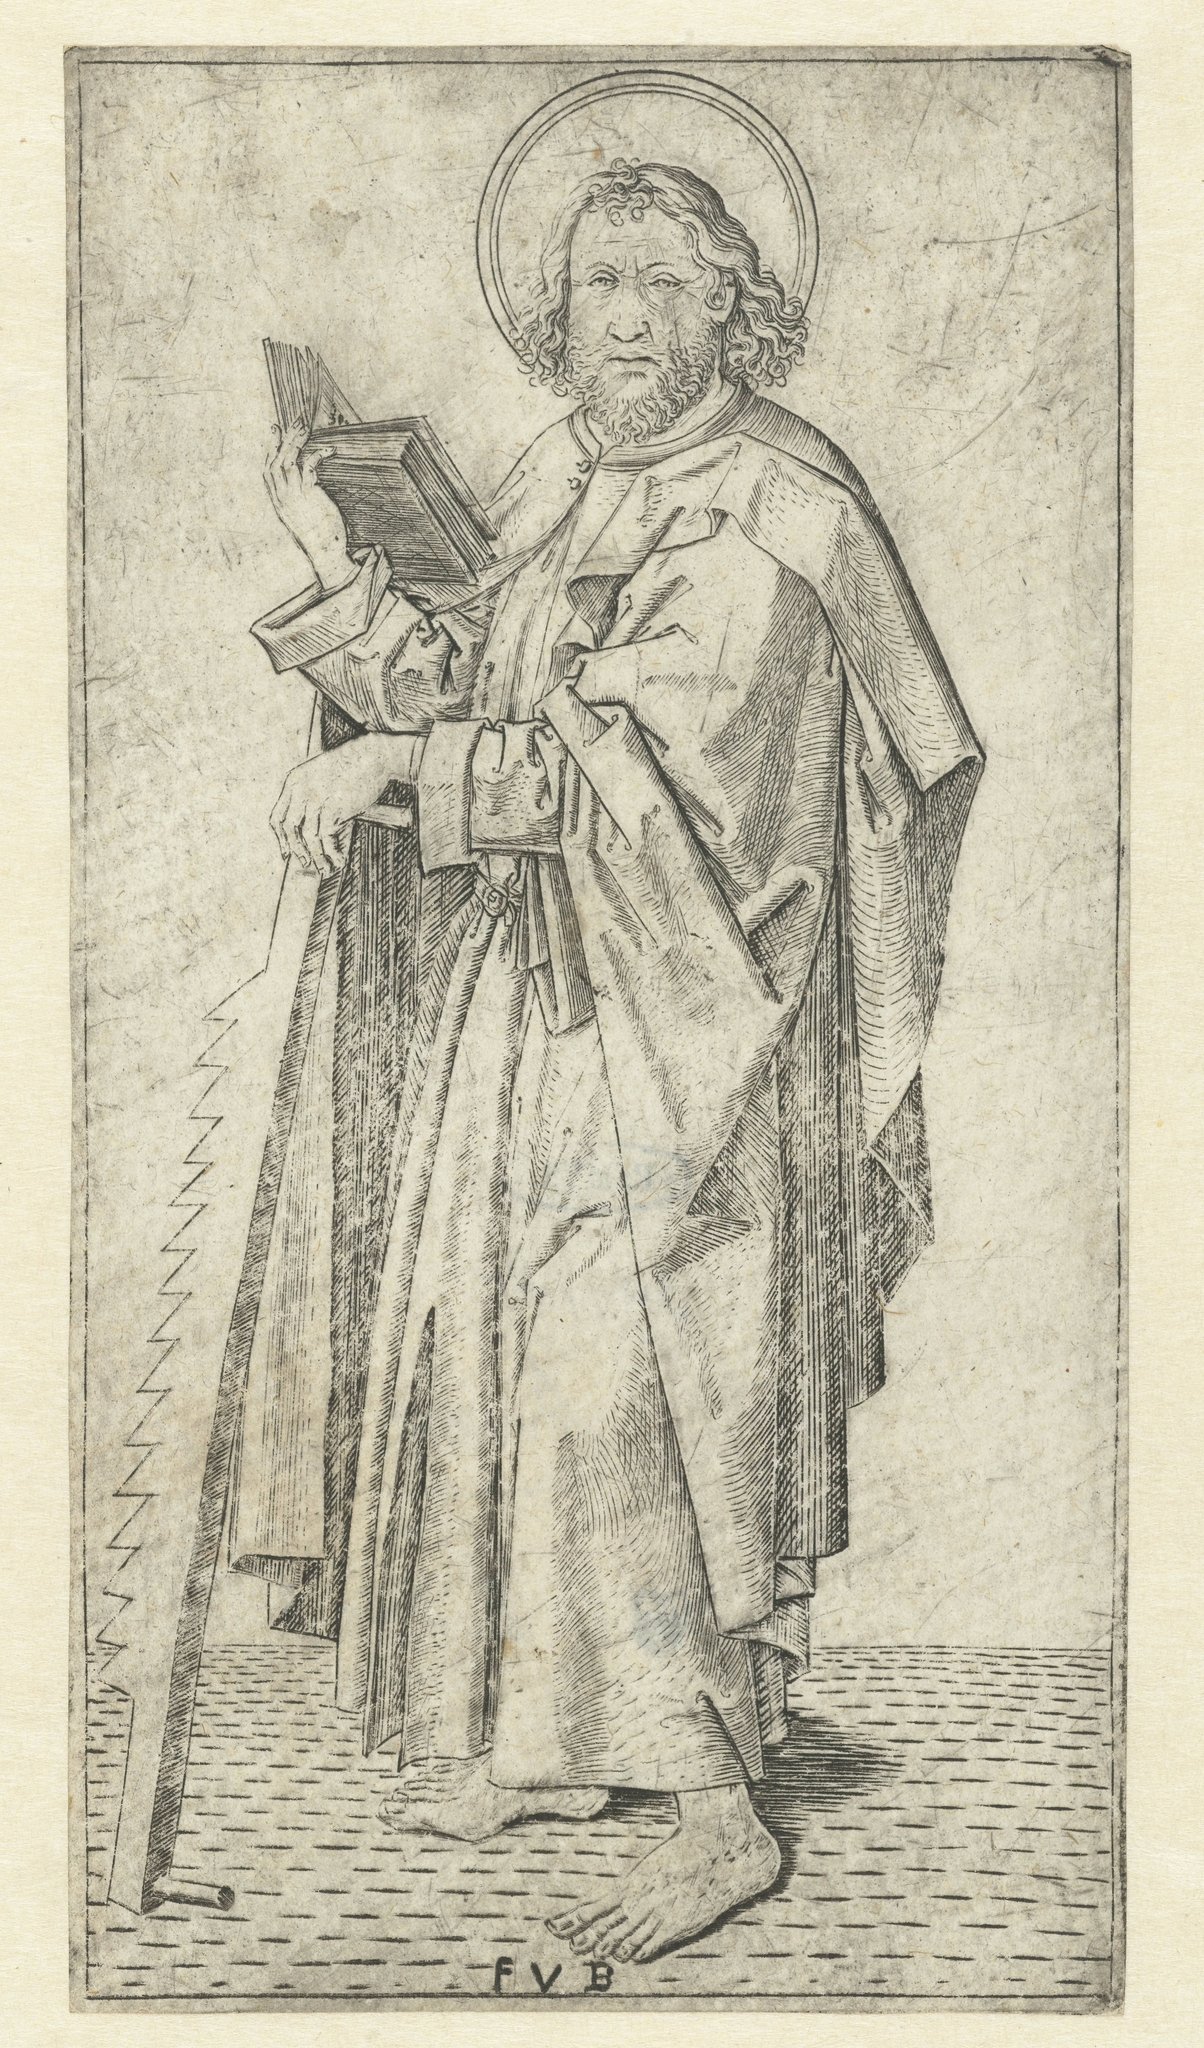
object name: print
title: Apostel Judas Thaddeus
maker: meester fvb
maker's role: print maker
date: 1475-1500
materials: paper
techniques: engraving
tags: the apostle simon zelotes (or simon the canaanite); possible attributes: book, saw, scroll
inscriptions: collector's mark: Lugt 2228, collector's mark: Lugt 2760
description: Afdruk van versleten plaat. Apostel blootsvoets met zaag en boek.